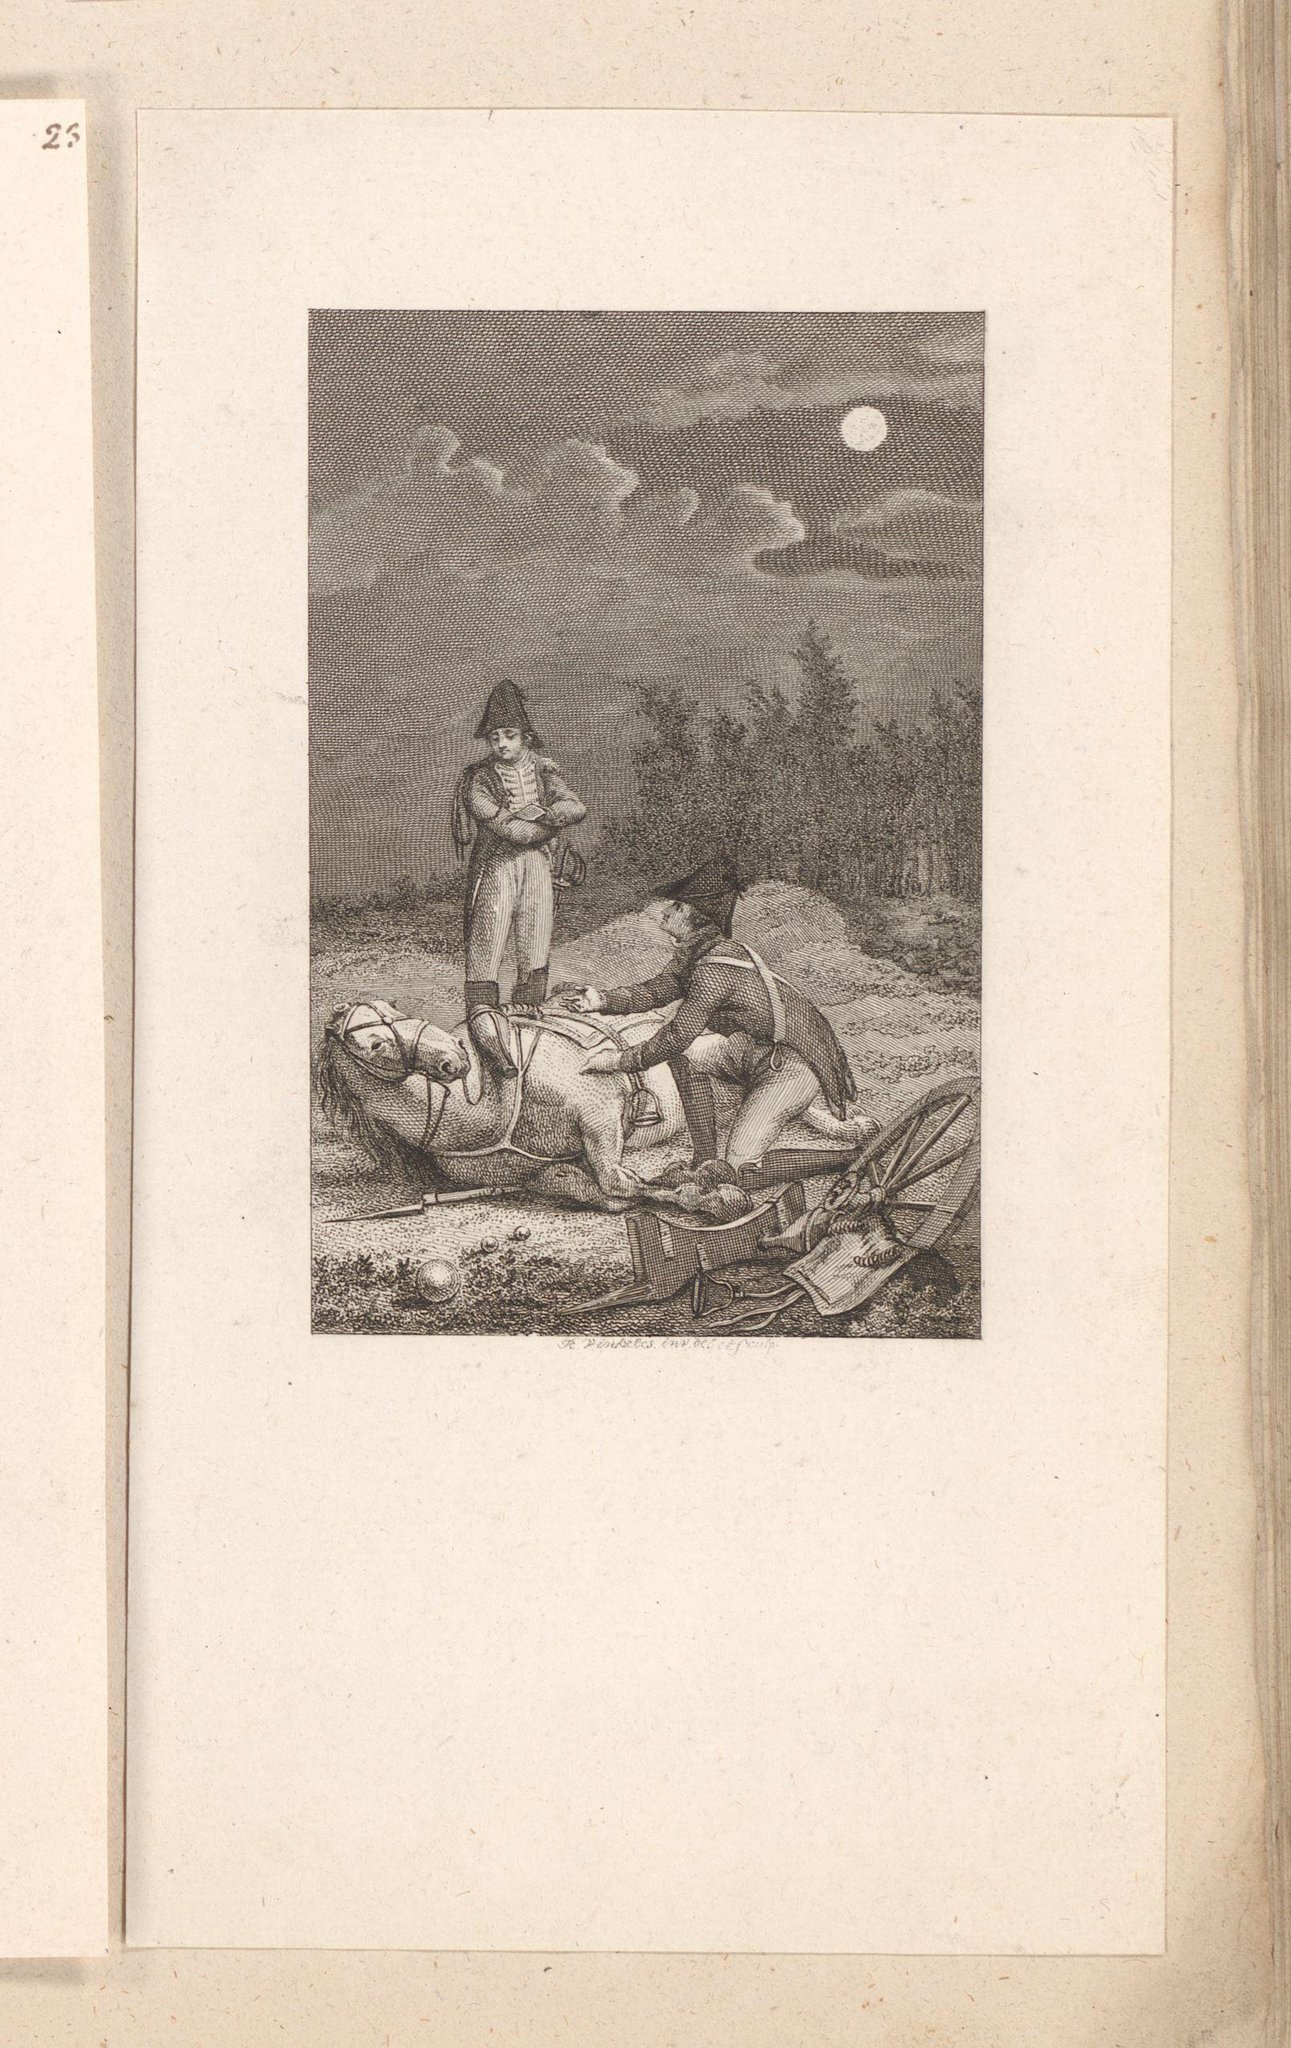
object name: album leaf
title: Reinoud Jan van Golstein en Frits bij een stervend paard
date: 1809-1810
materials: paper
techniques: engraving, etching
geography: haarlem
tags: the soldier; the soldier's life, horse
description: Proefdruk van een boekillustratie gebruikt in: Loosjes, Adriaan Pietersz. Lotgevallen van den heere Reinoud Jan van Golstein tot Scherpenzeel. Vier delen. Haarlem: A. Loosjes, 1809-1810.